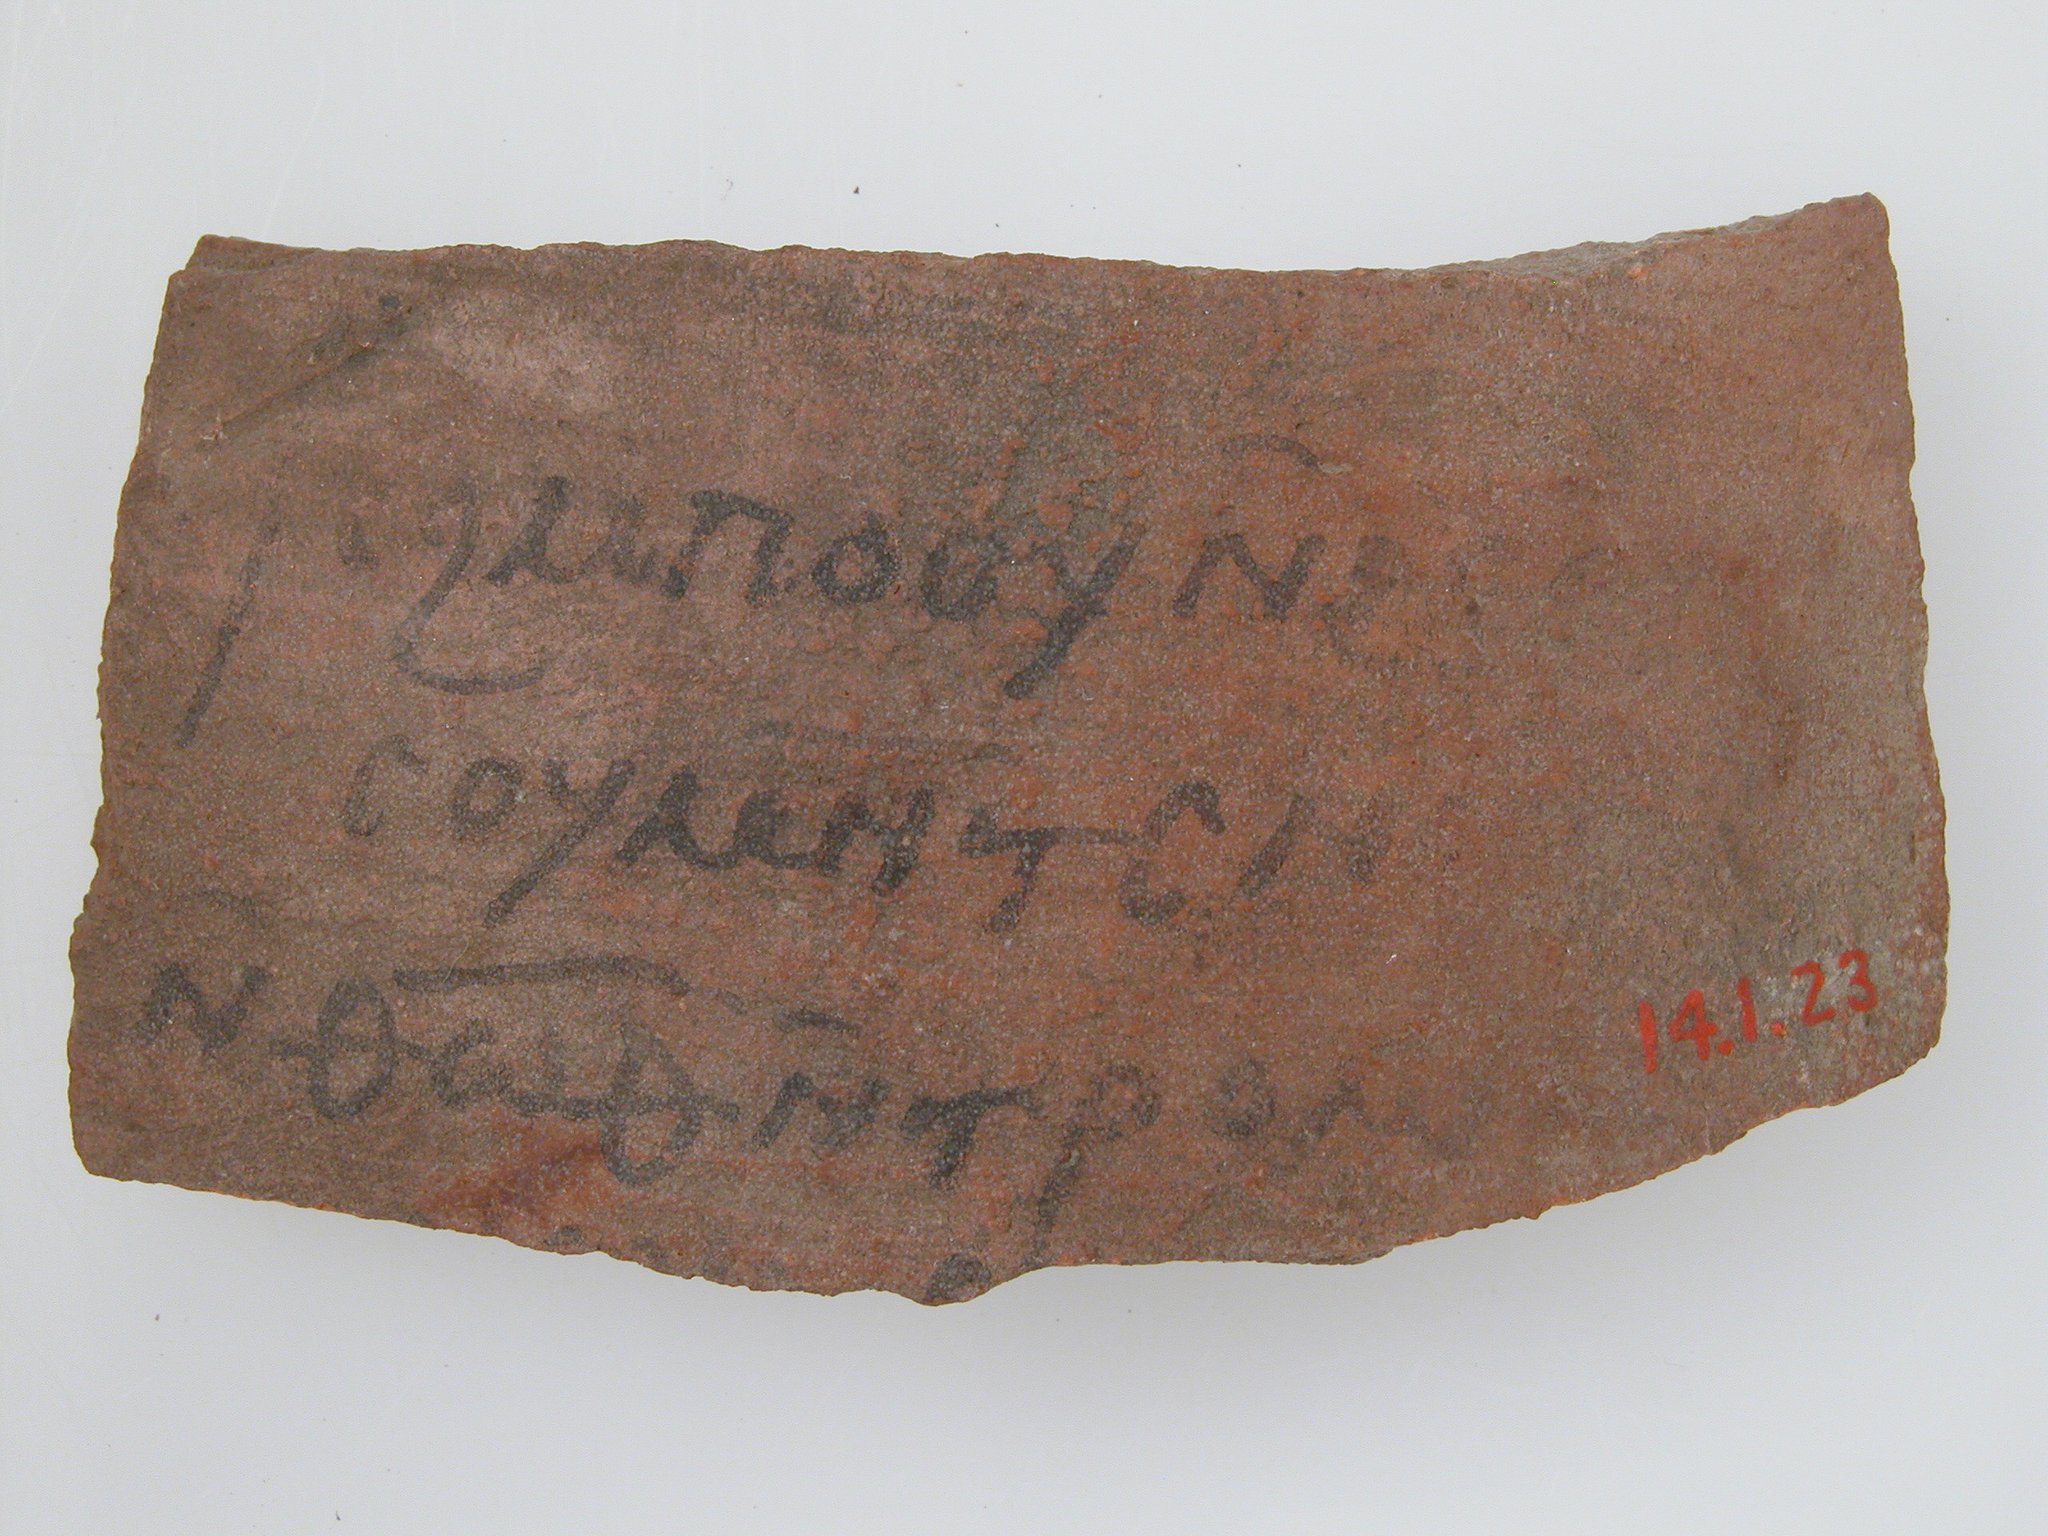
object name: ostrakon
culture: coptic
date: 600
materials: ink, pottery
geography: egypt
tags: coptic,documents